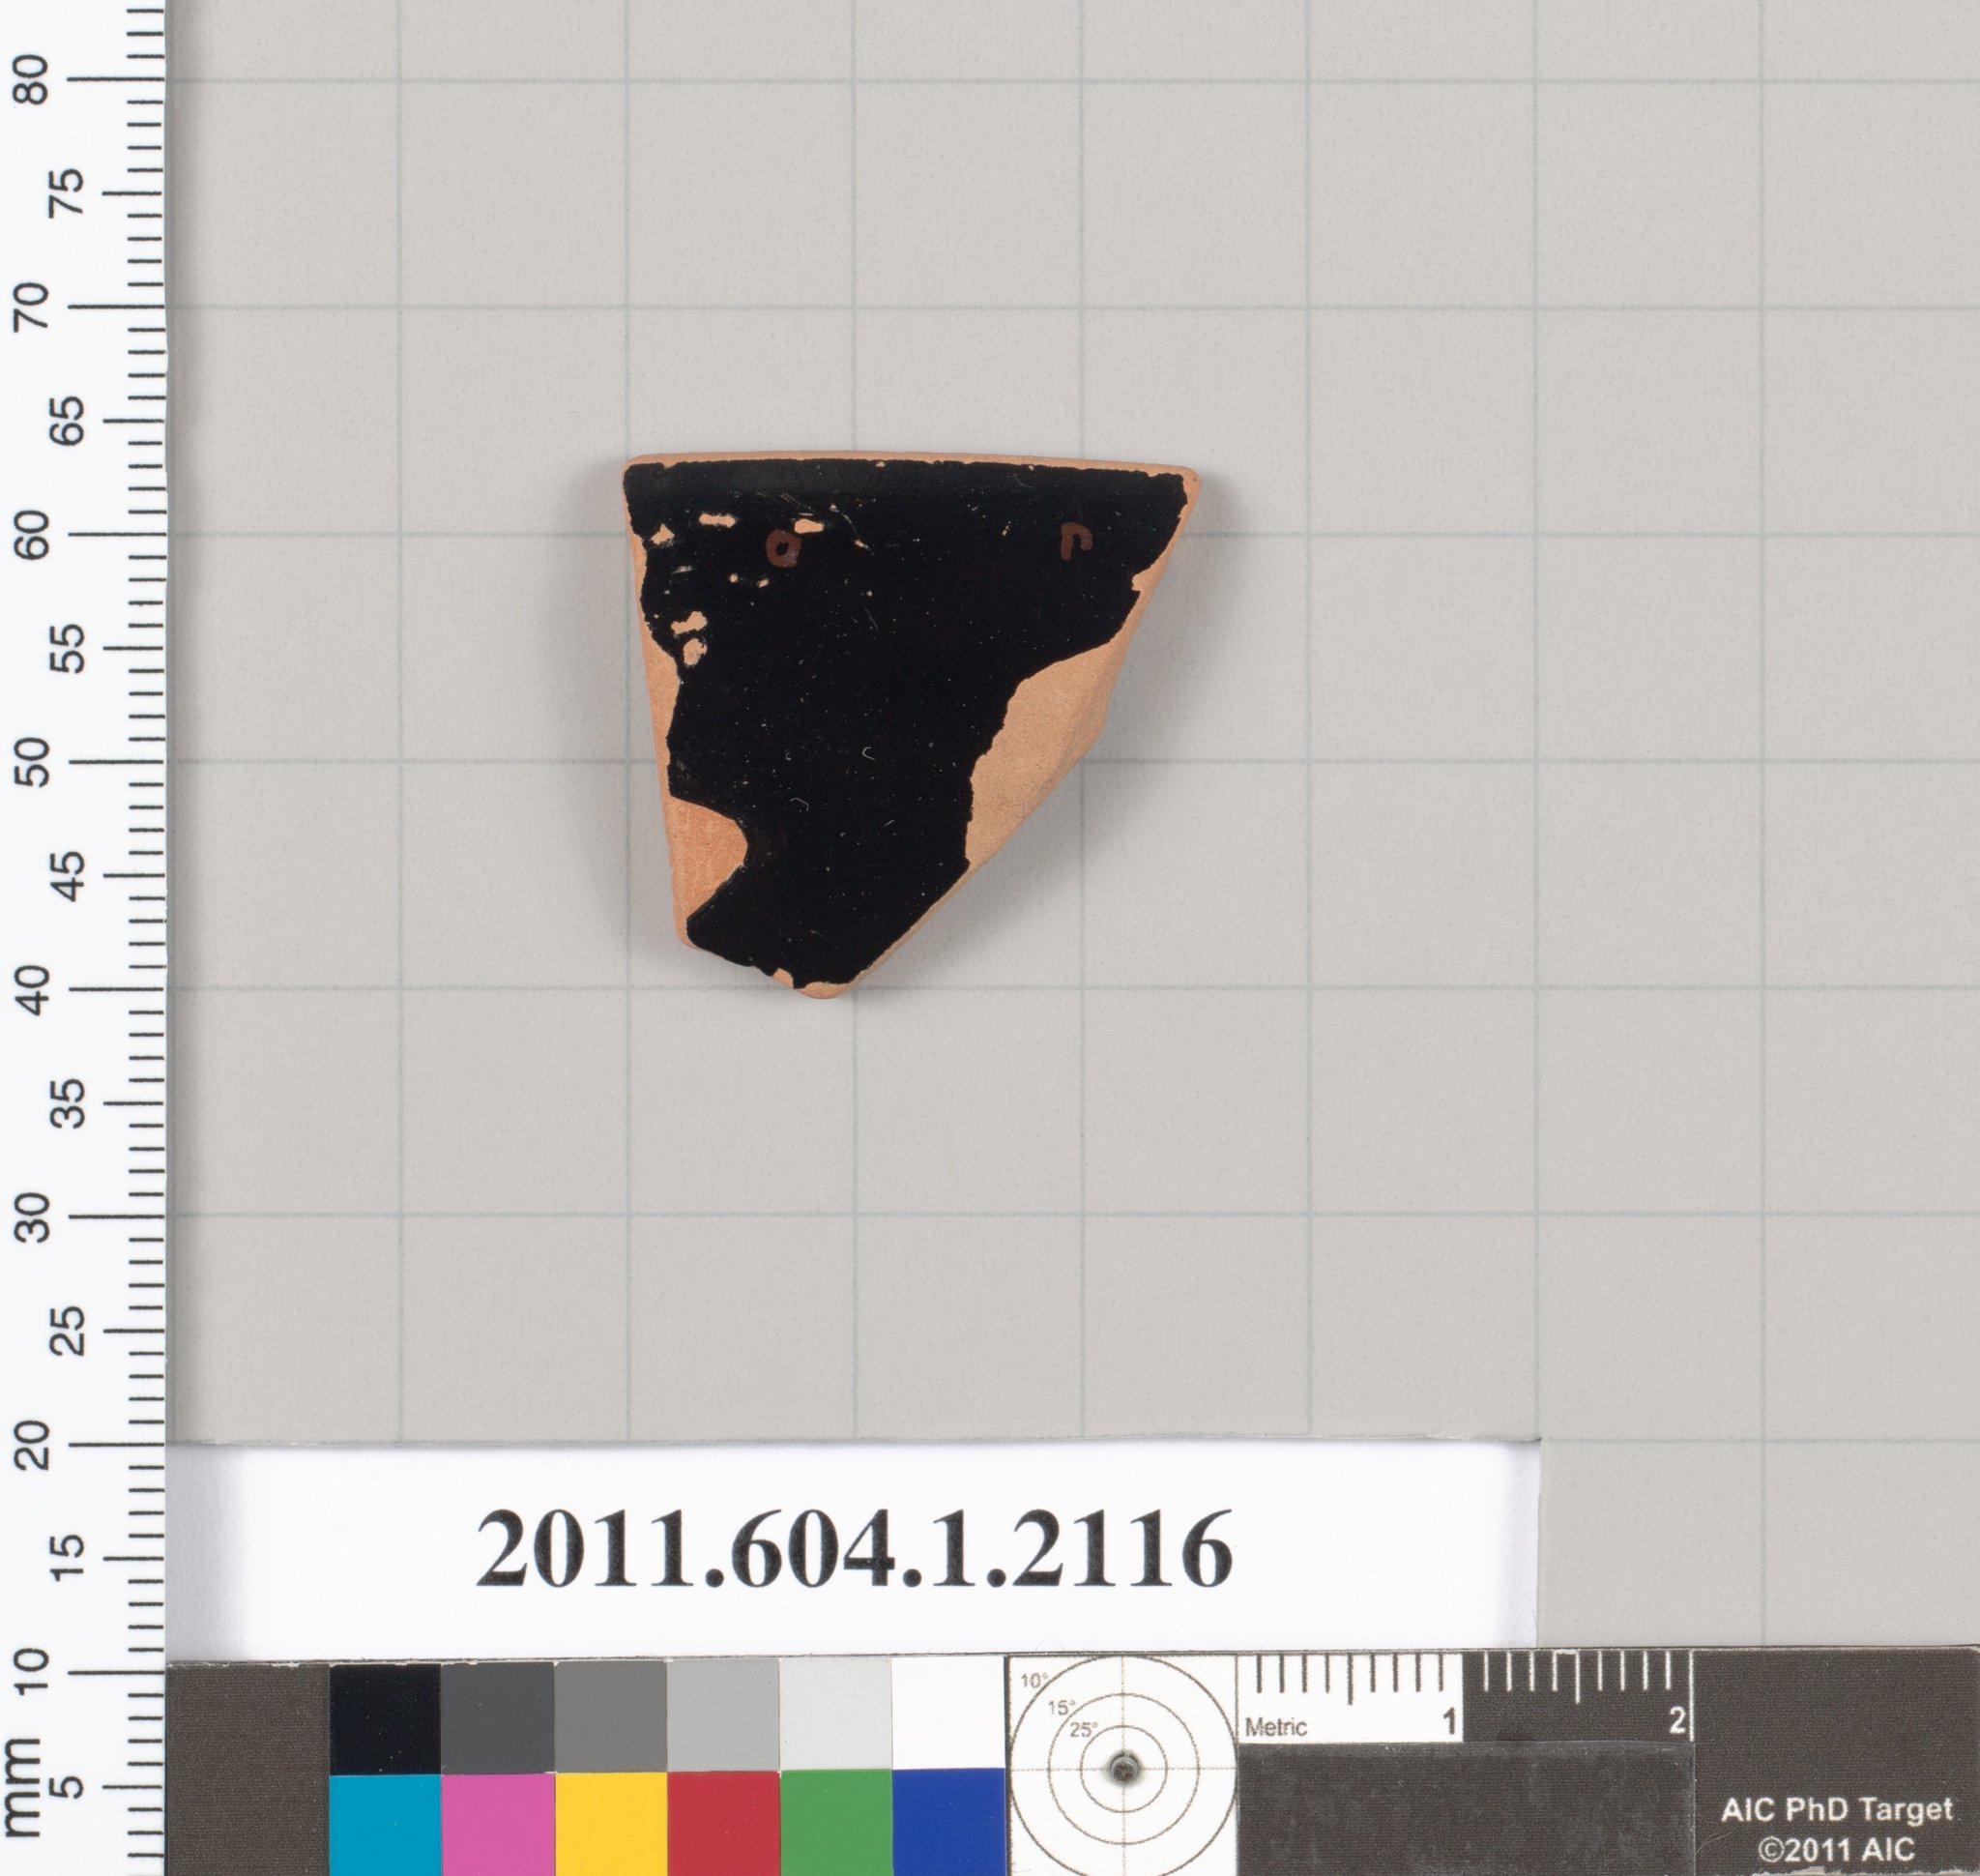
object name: kylix fragment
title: Terracotta rim fragment of a kylix (drinking cup)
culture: greek, attic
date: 500-401 BCE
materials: terracotta